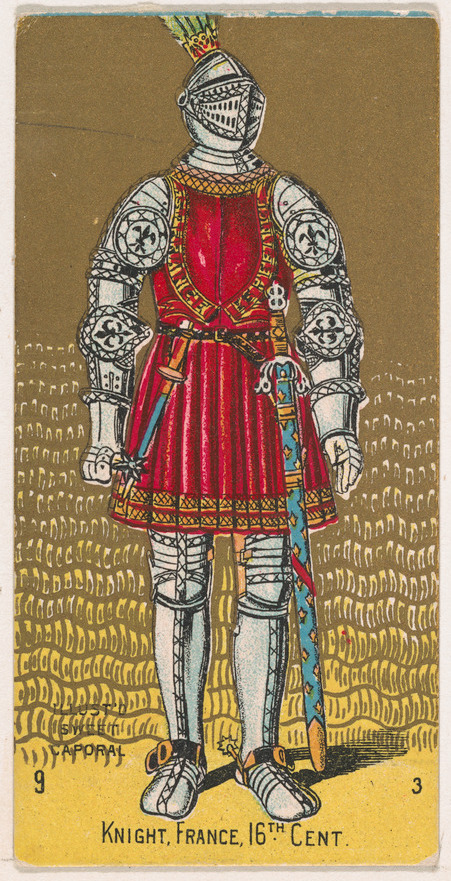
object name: print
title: Knight, France, 16th Century, from the Military Series (N224) issued by Kinney Tobacco Company to promote Sweet Caporal Cigarettes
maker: kinney brothers tobacco company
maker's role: publisher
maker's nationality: american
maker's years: 1869-2011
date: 1888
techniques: color lithograph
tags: military,armor,knights